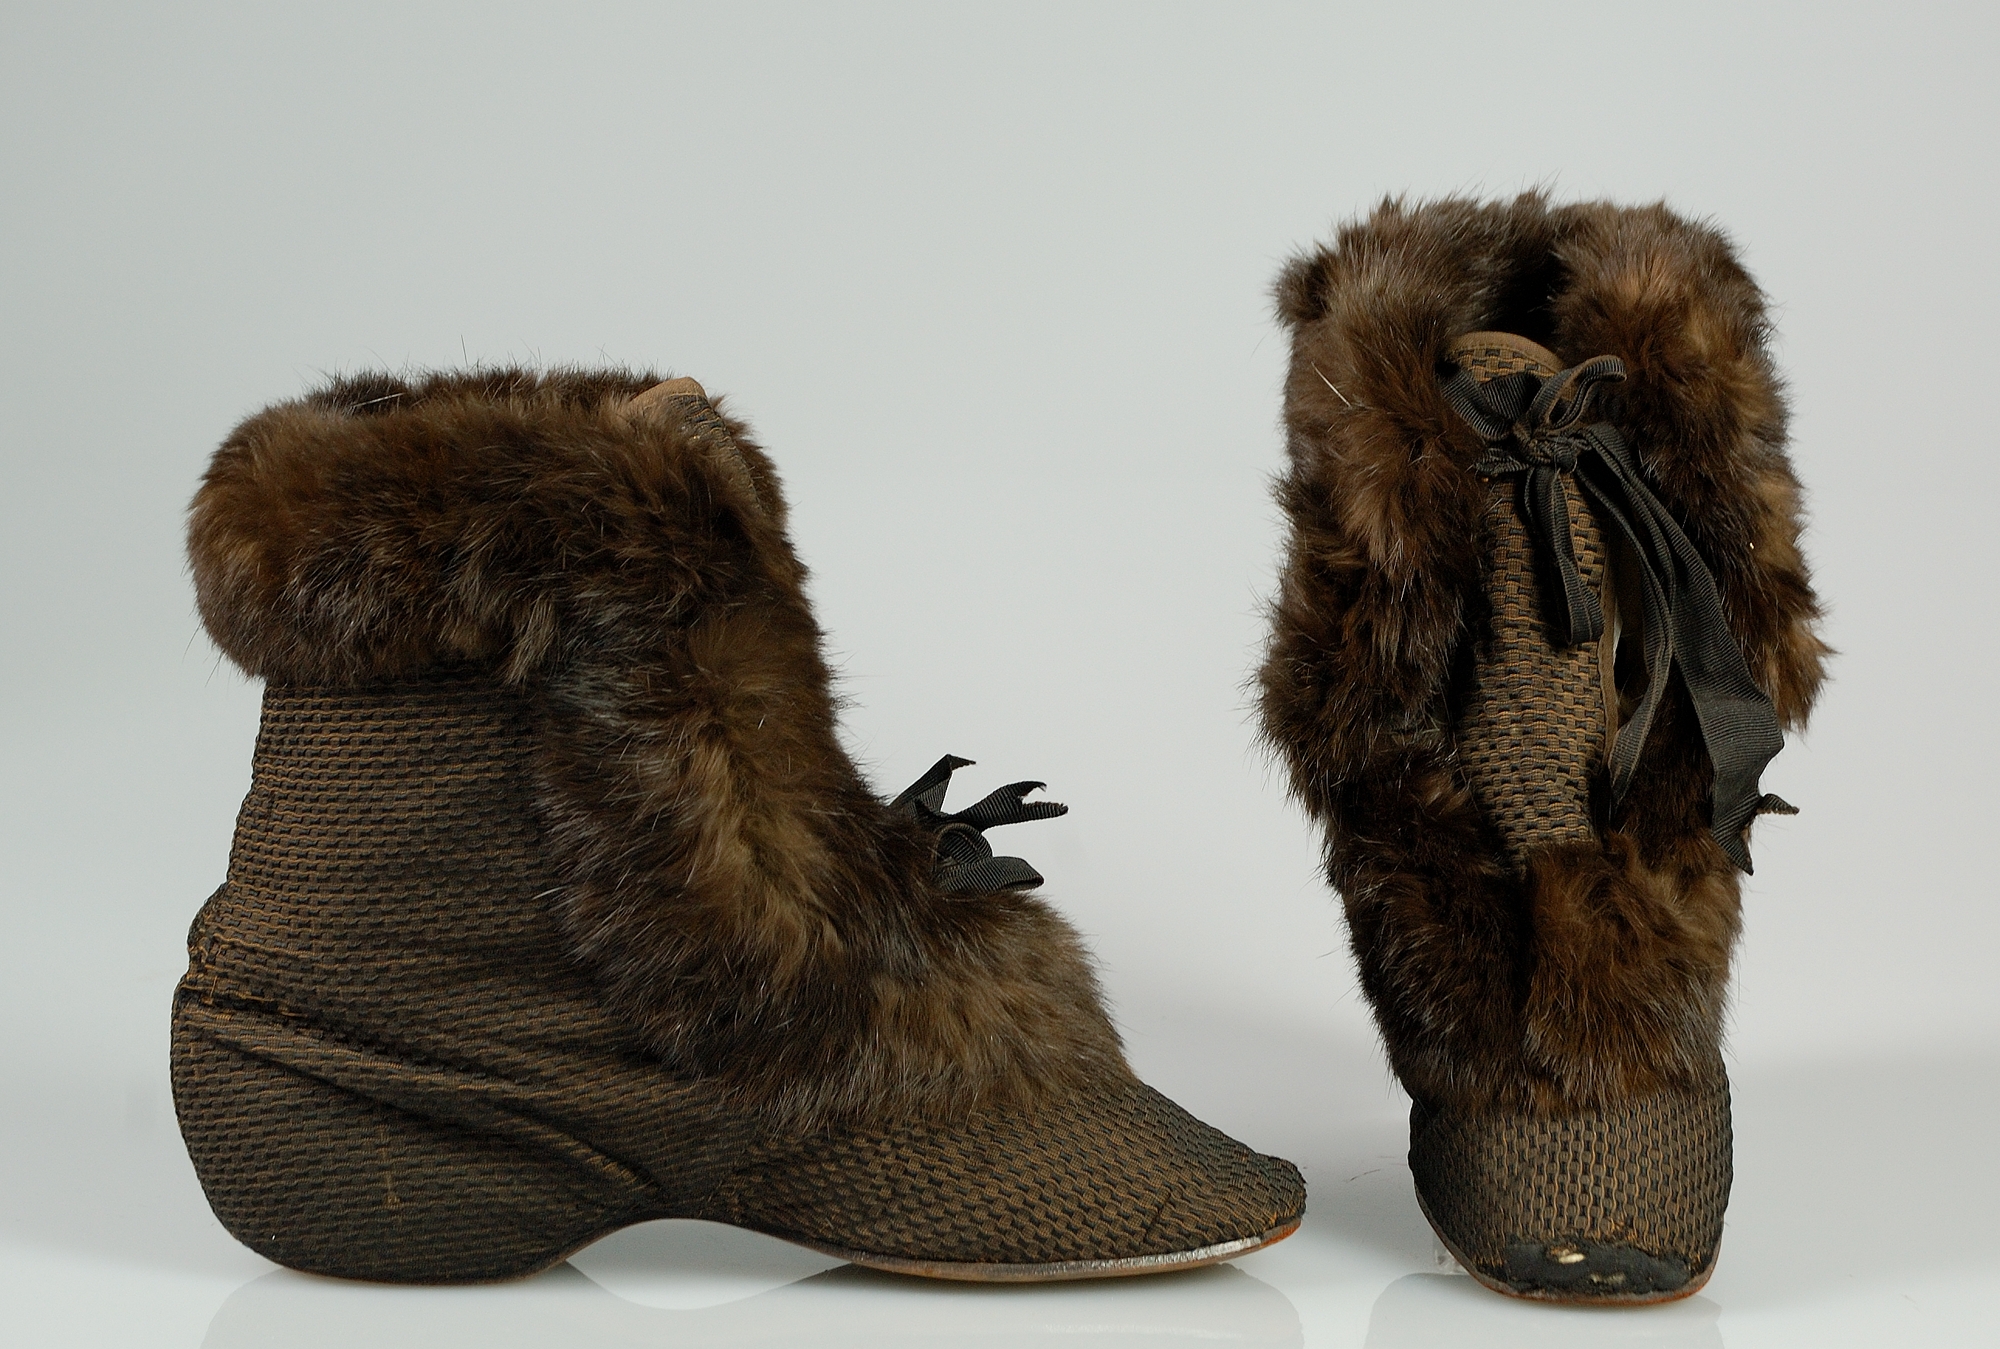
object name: carriage boot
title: Carriage boots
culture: french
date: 1880-1895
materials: fur, silk